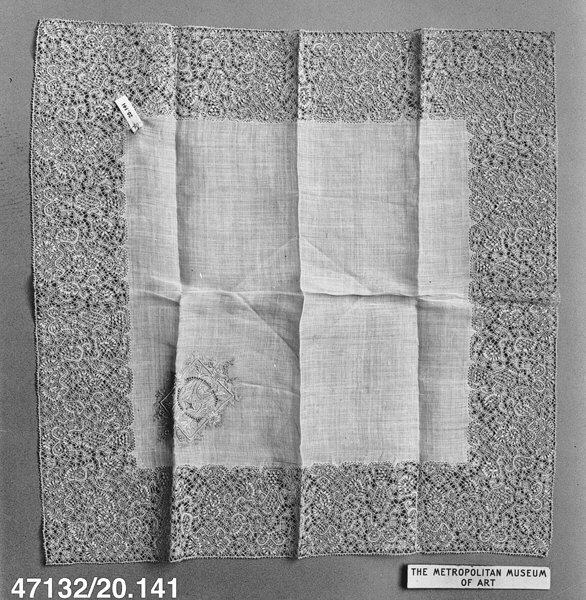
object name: handkerchief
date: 1801-1900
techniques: lace